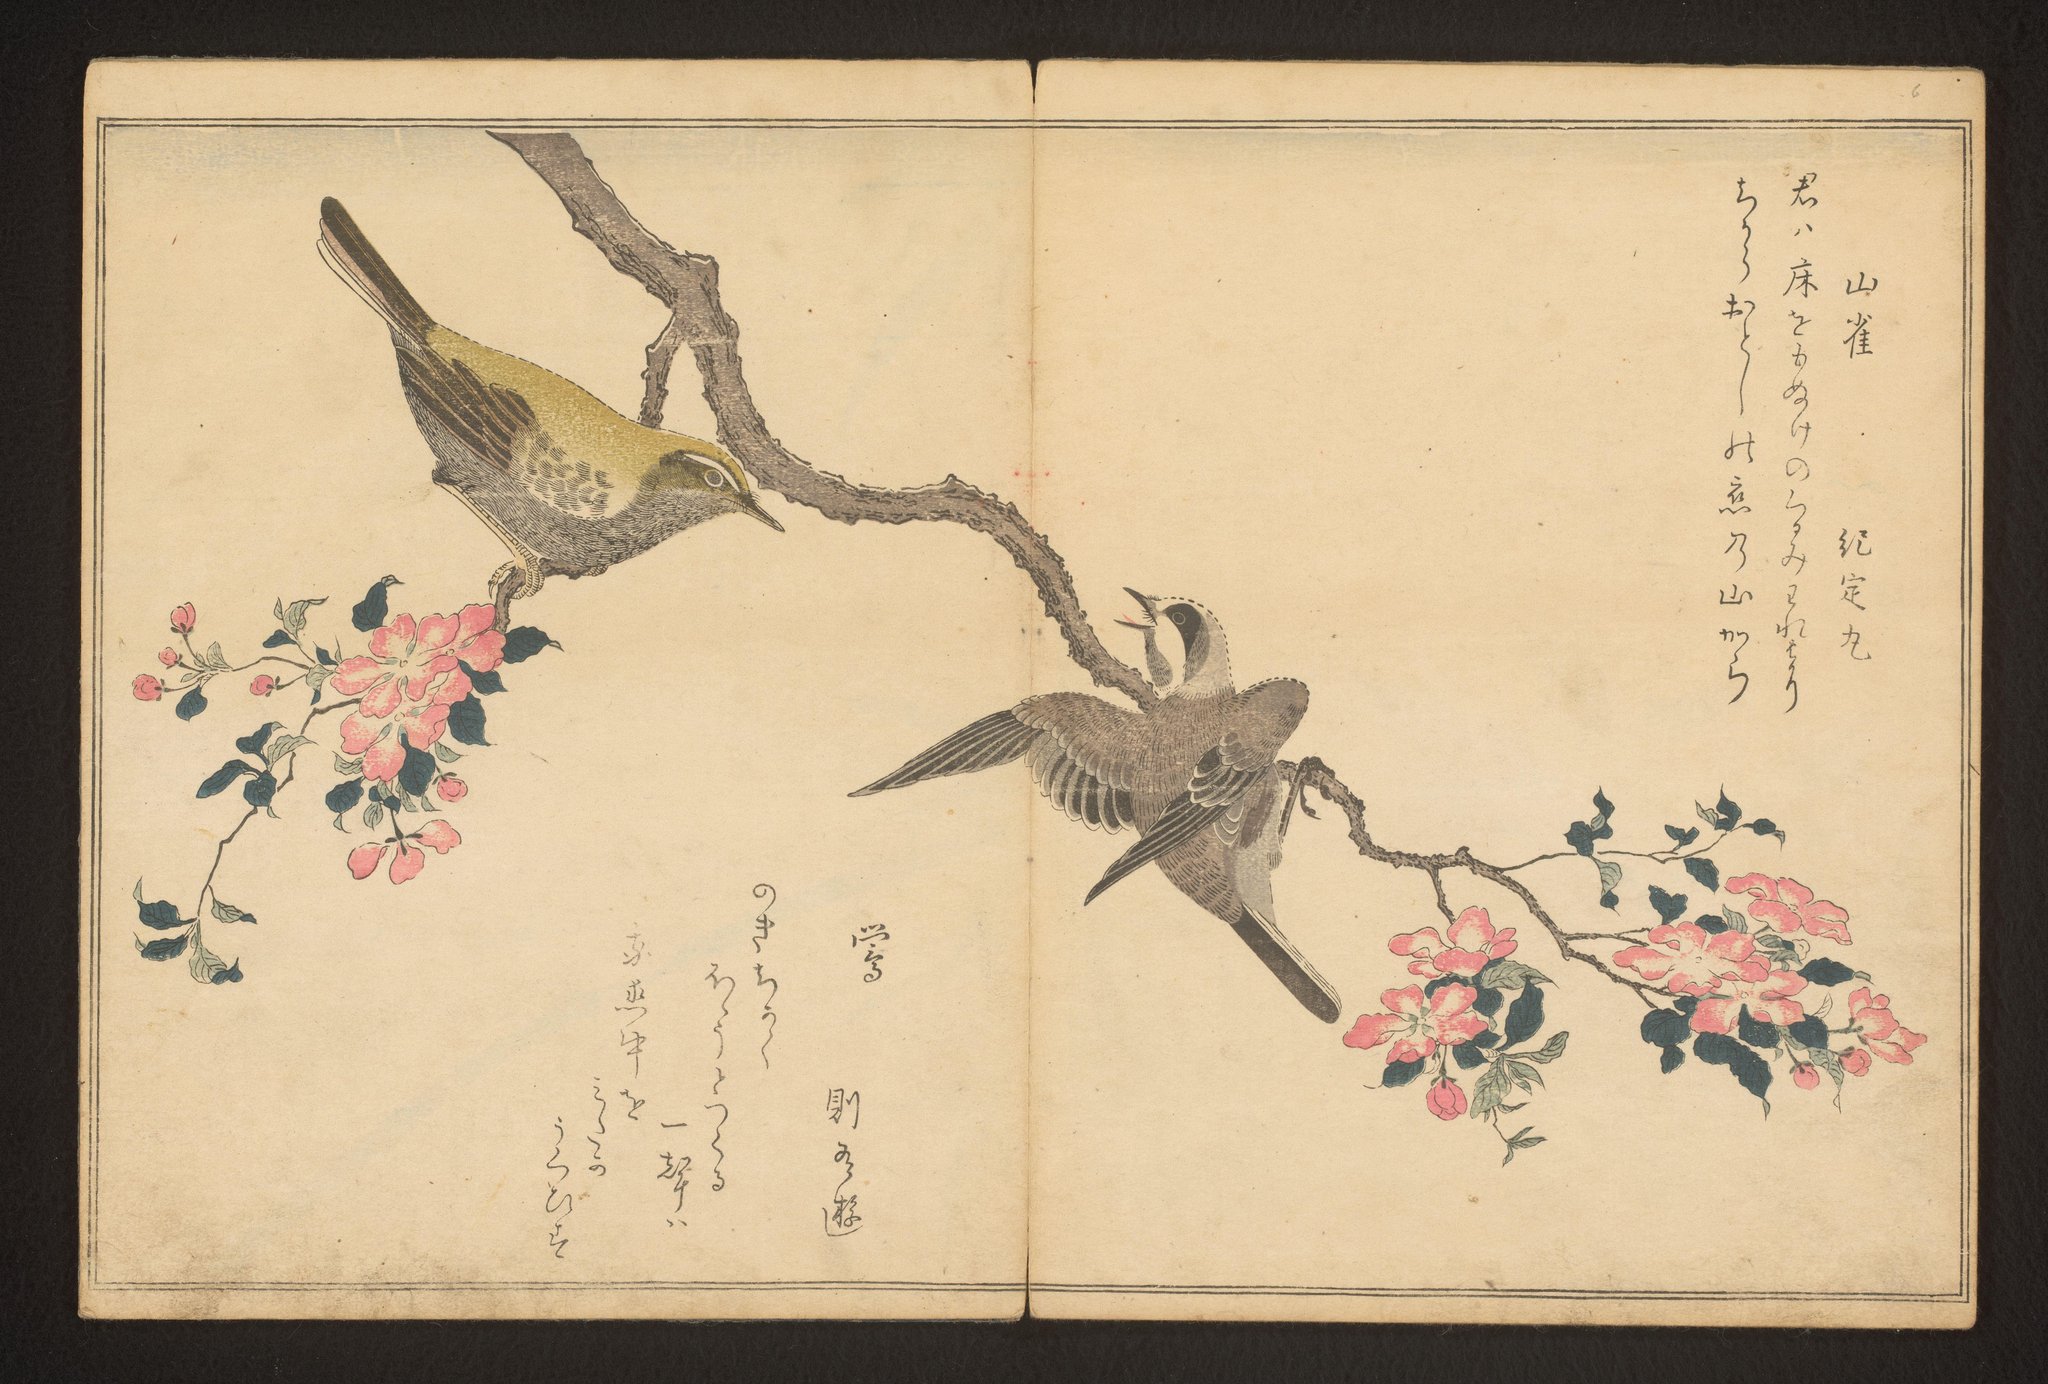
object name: page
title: Tit and bush warbler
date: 1796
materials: paper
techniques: woodcut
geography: edo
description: Dertiende en veertiende pagina van het vogelboek van Utamaro.